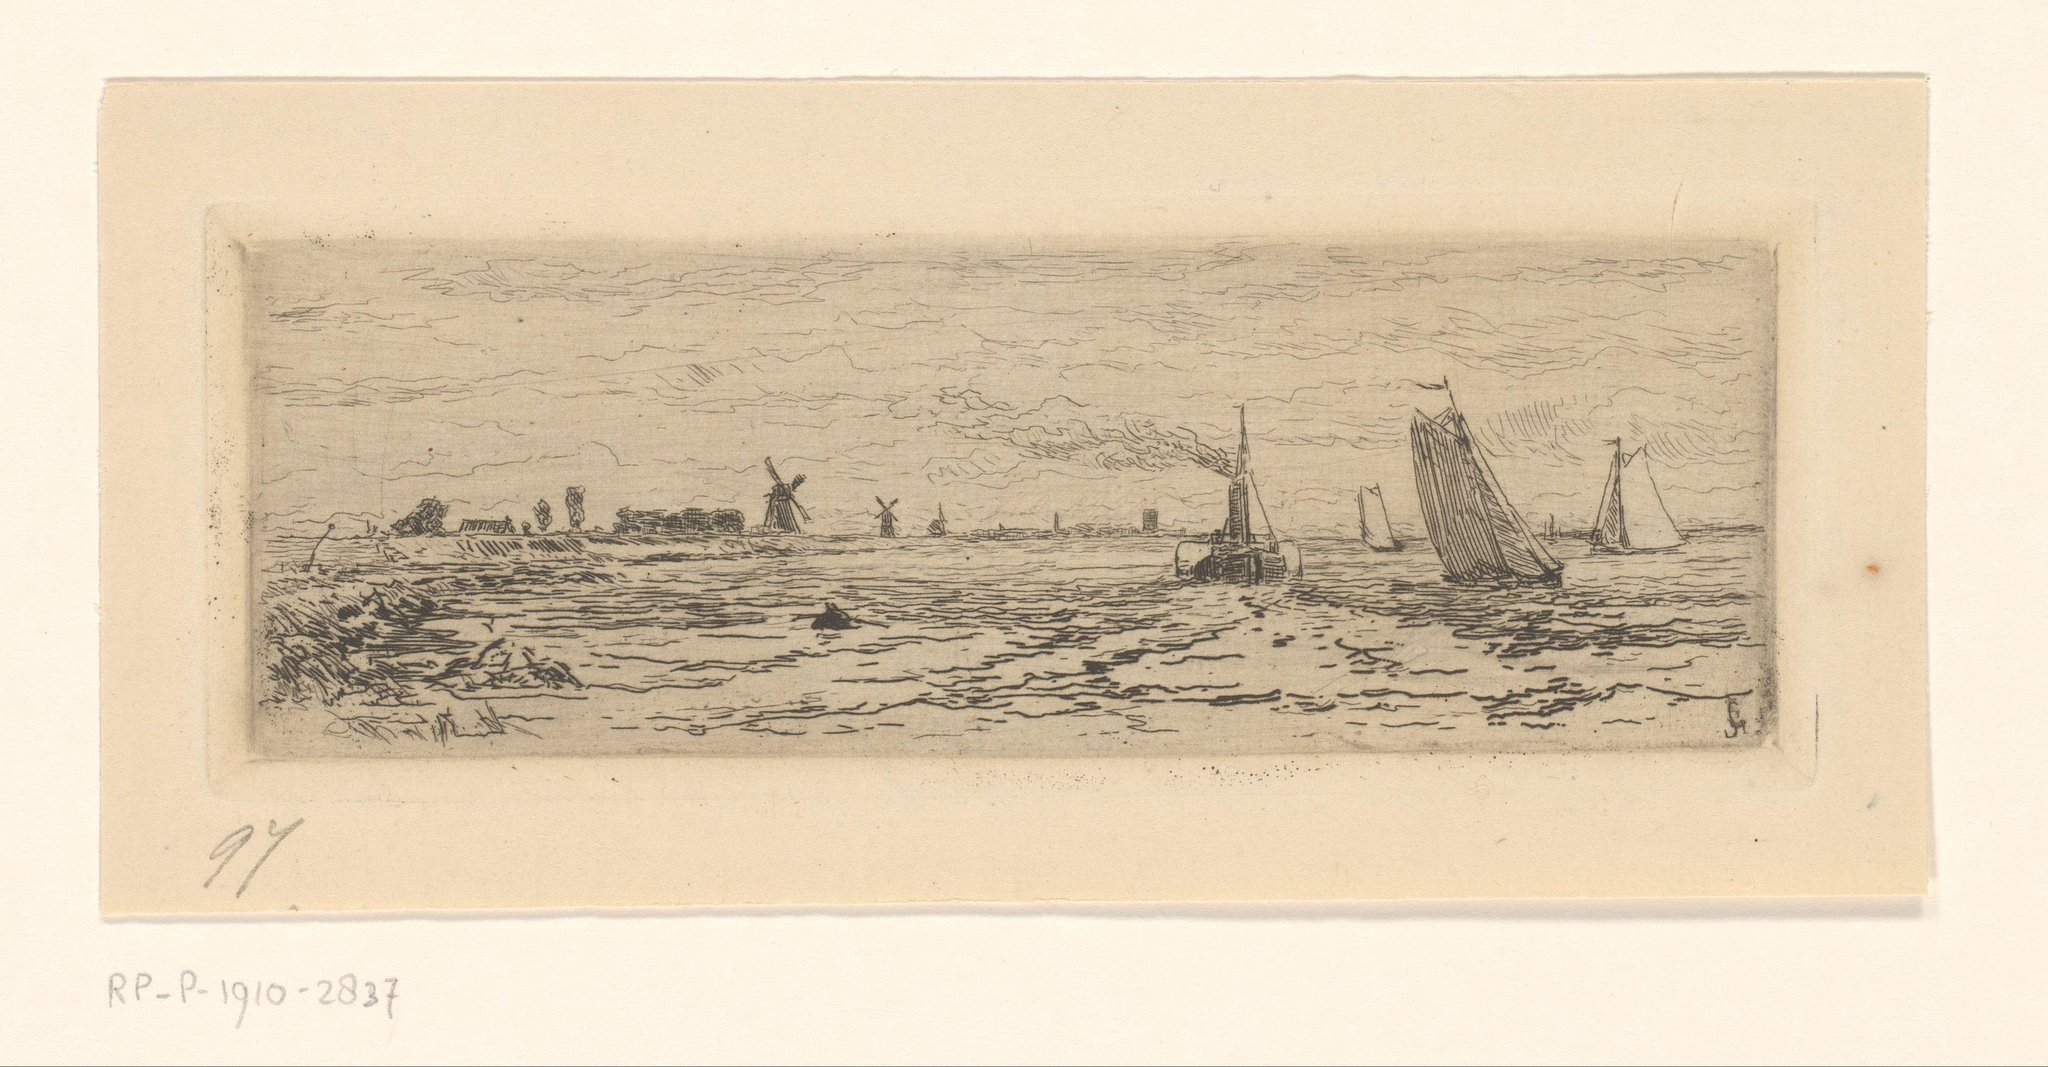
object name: print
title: Gezicht op de Maas tussen Dordrecht en Rotterdam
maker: carel nicolaas storm van s-gravesande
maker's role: draughtsman, print maker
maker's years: 1841-1924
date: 1877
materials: paper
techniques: etching, intaglio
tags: river, ships (in general), windmill in landscape, dordrecht, rotterdam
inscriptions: collector's mark: Lugt 2228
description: Links op de oever een rij molens. Rechts op het water zeilschepen en een stoomboot.